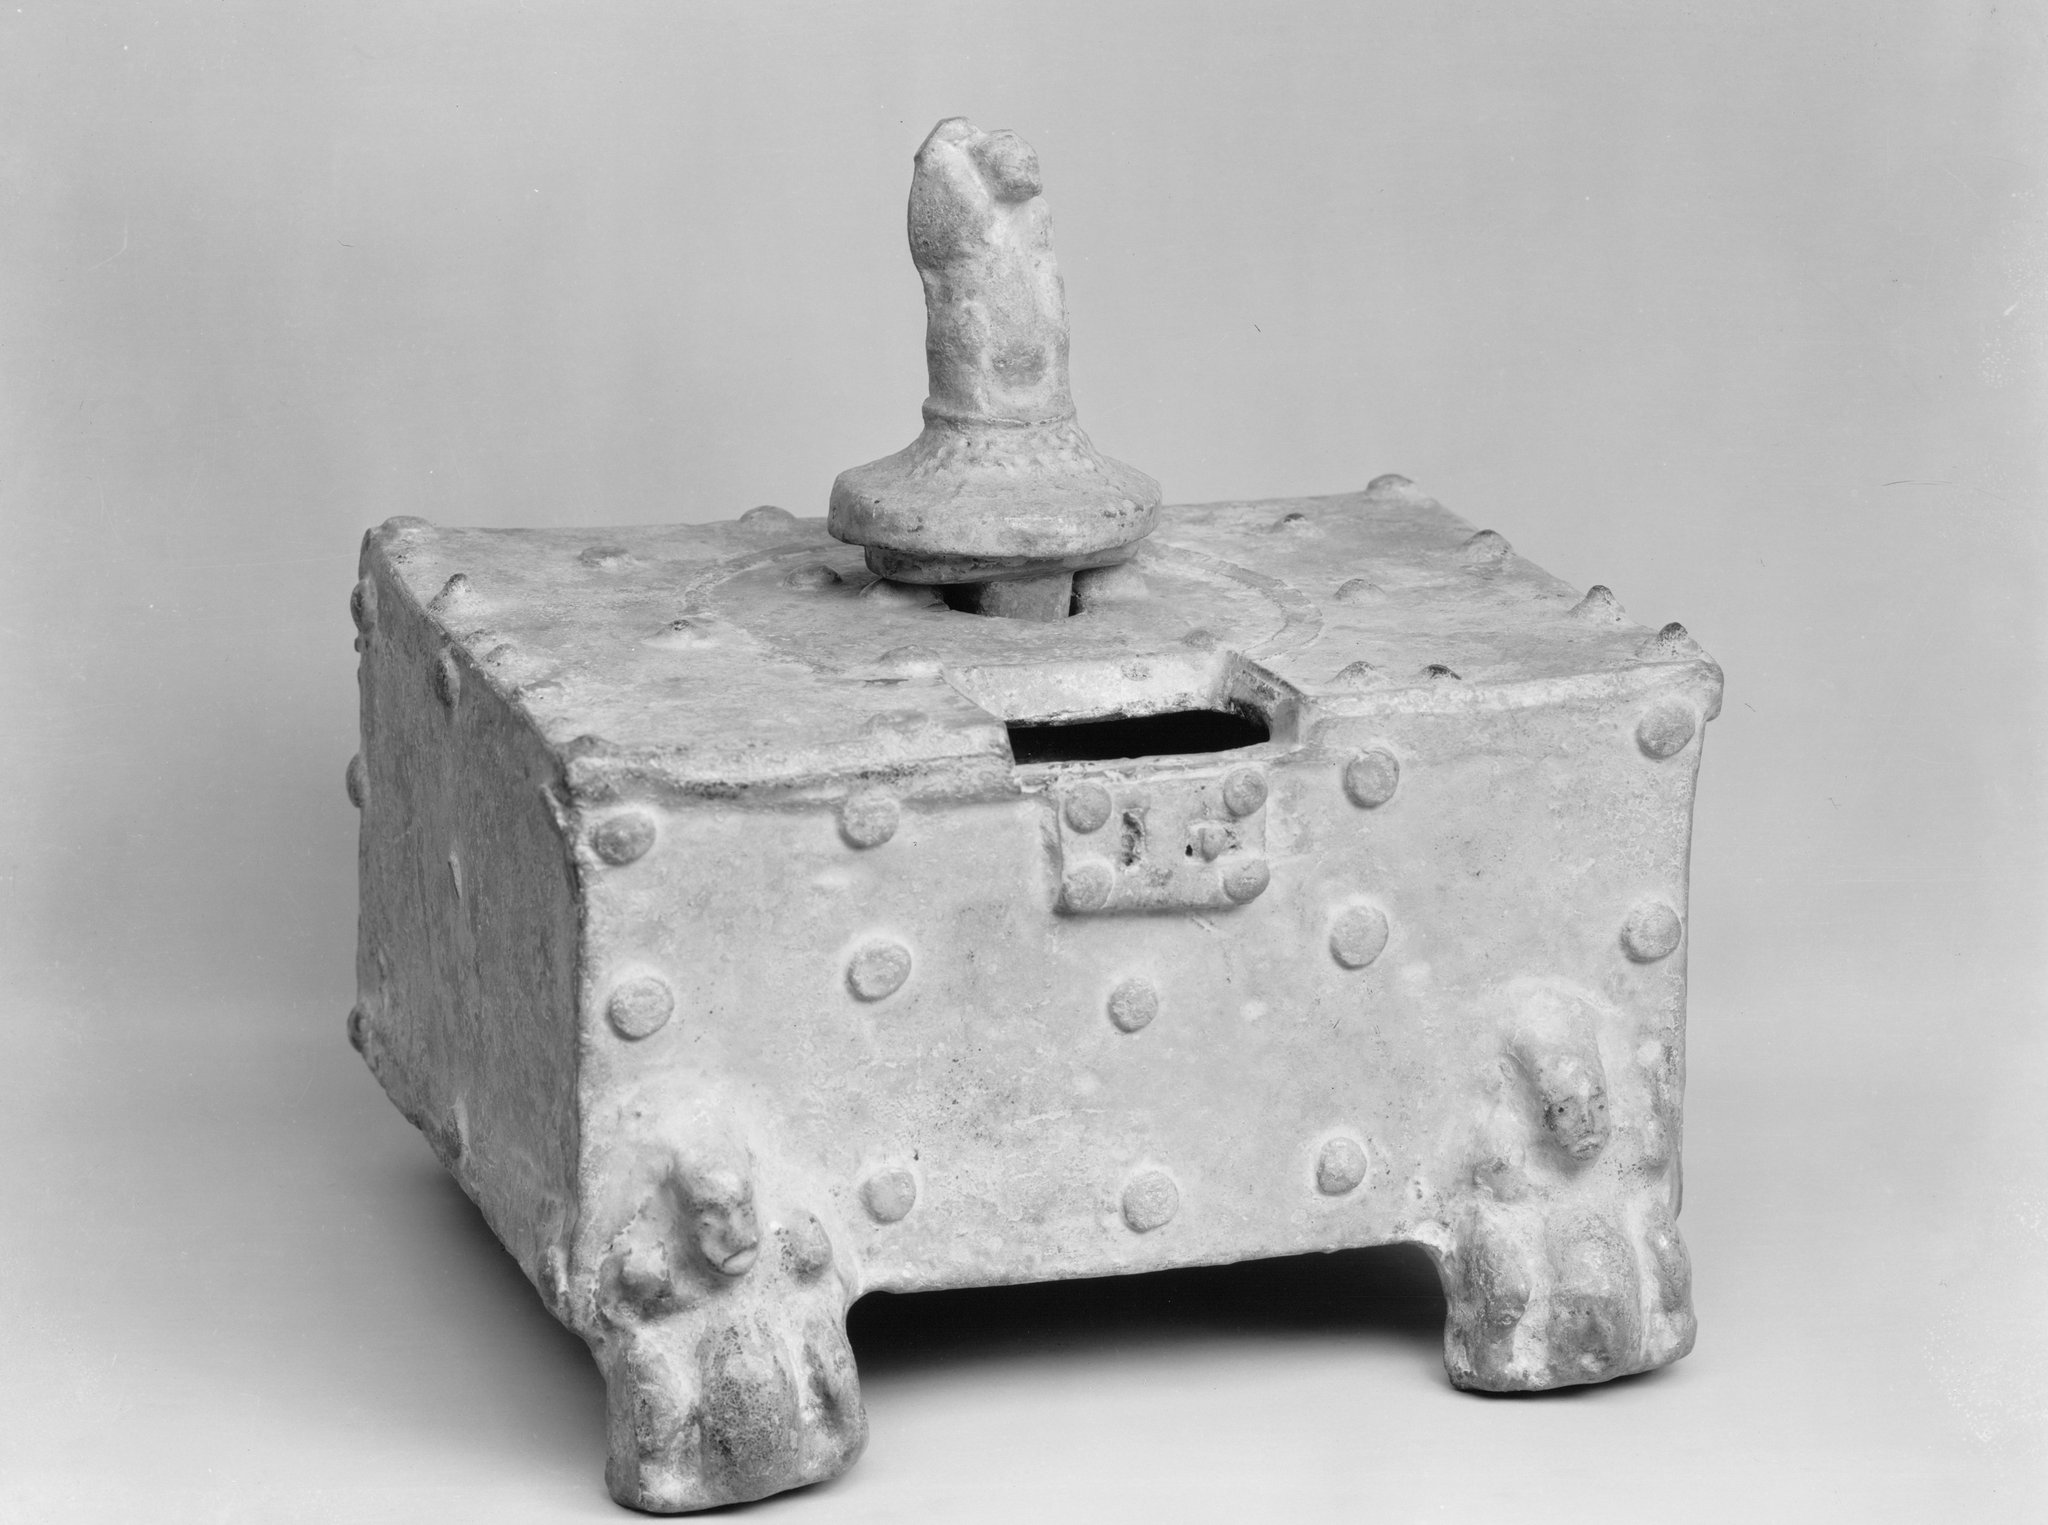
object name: alms box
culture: chinese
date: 206 BCE-220 CE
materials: stoneware